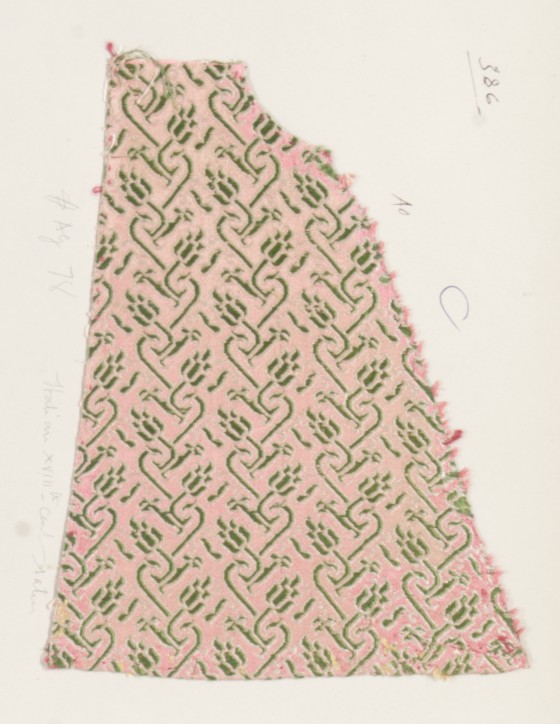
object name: fragment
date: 1601-1800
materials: silk